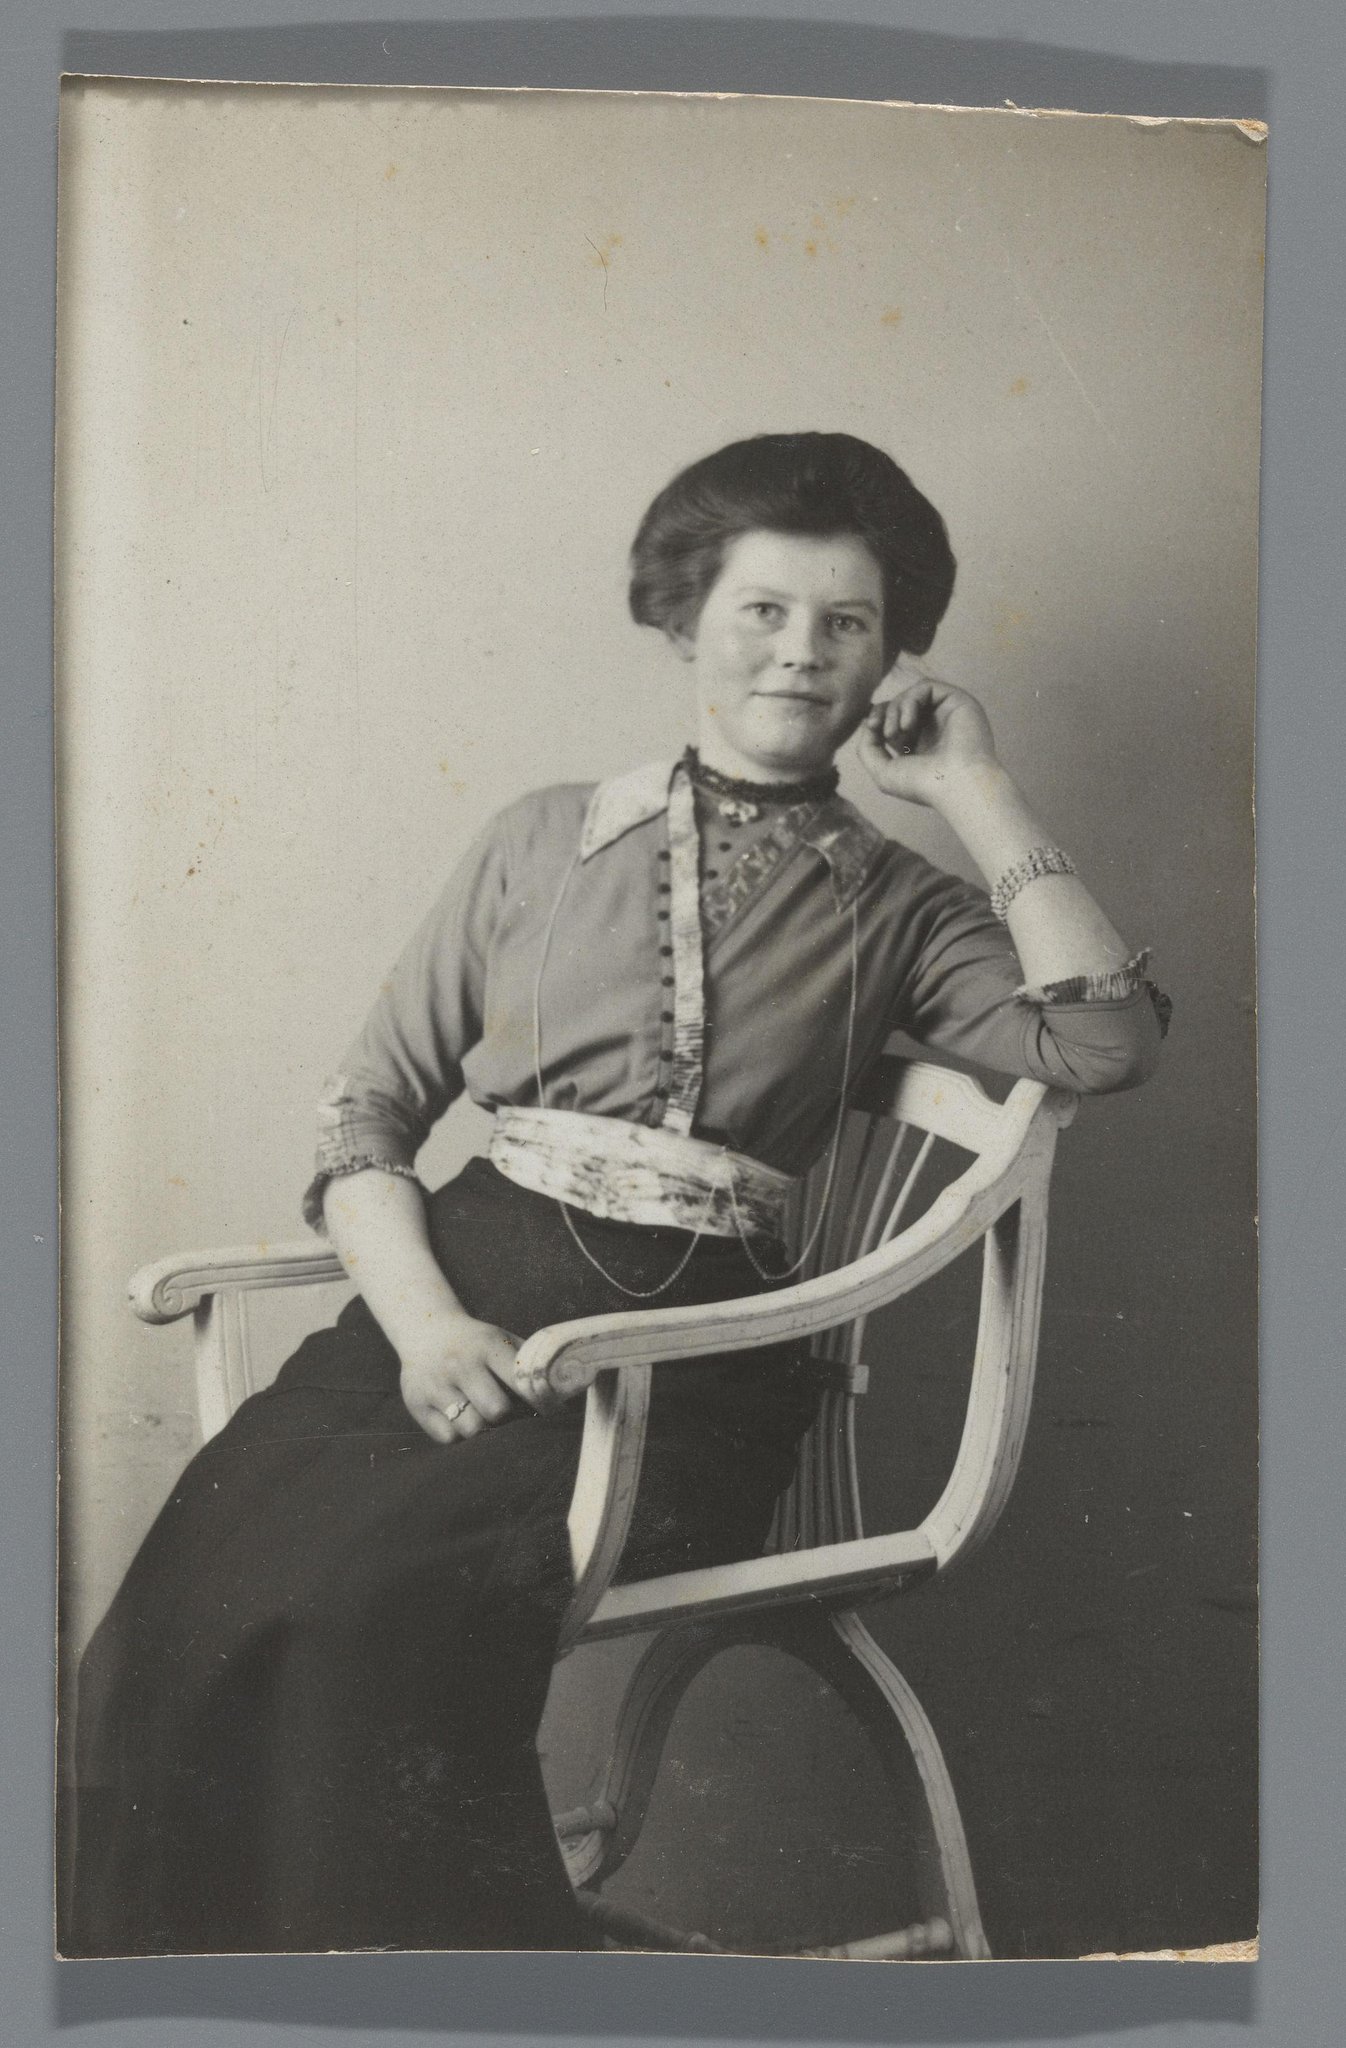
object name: snapshot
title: Portret van een vrouw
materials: photographic support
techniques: gelatin silver print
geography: groningen